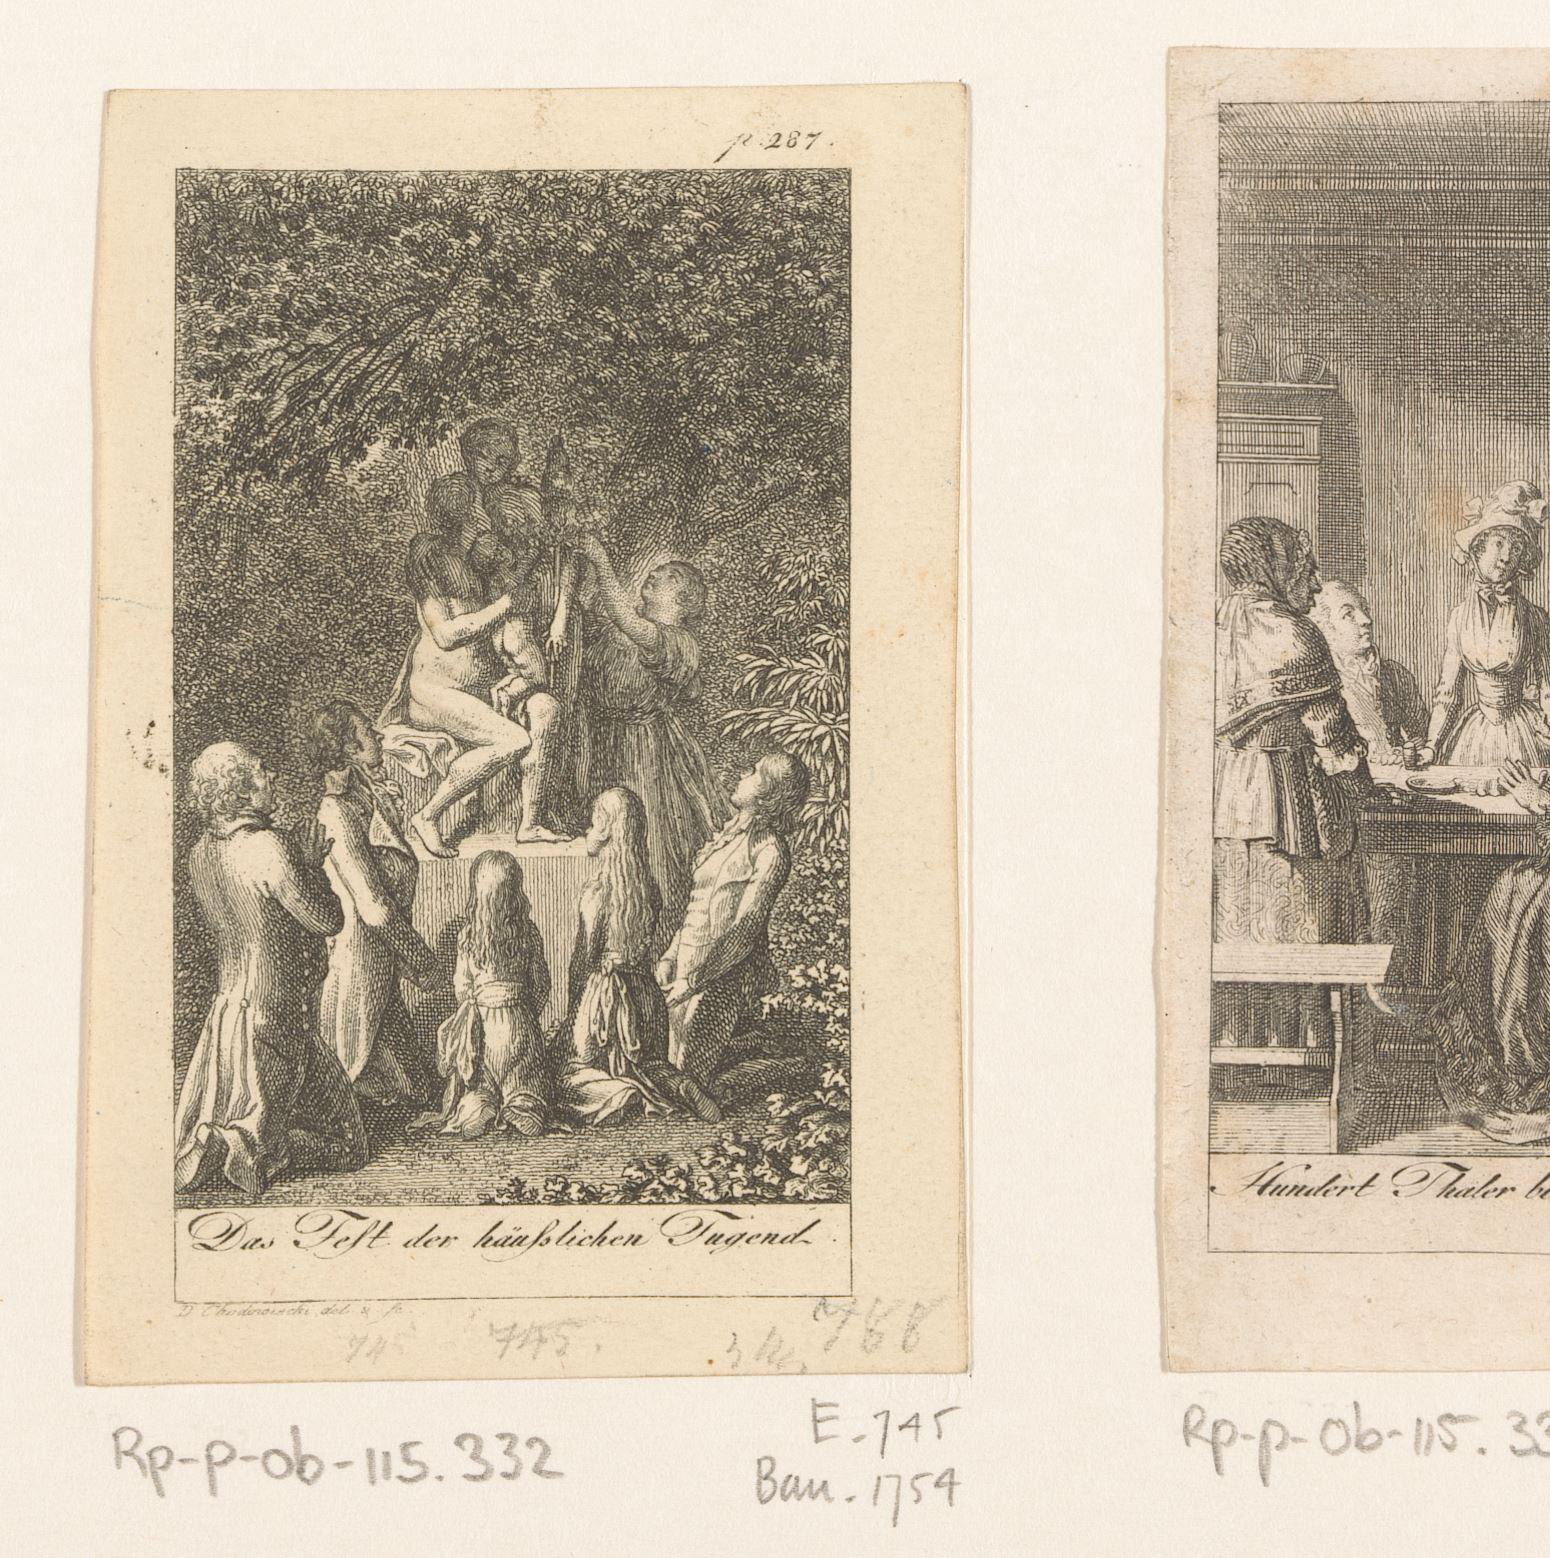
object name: print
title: Amalie legt een krans bij het monument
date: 1794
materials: paper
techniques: etching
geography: berlin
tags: flowers, monument, statue, family, descendance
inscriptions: collector's mark: Lugt 2228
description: Prent gebruikt voor: Ehrenberg, Friedrich. Leipziger Taschenbuch für Frauenzimmer zum Nutzen und Vergnügen auf das Jahr 1795. Leipzig: Adam Friedrich Böhme, s.a.